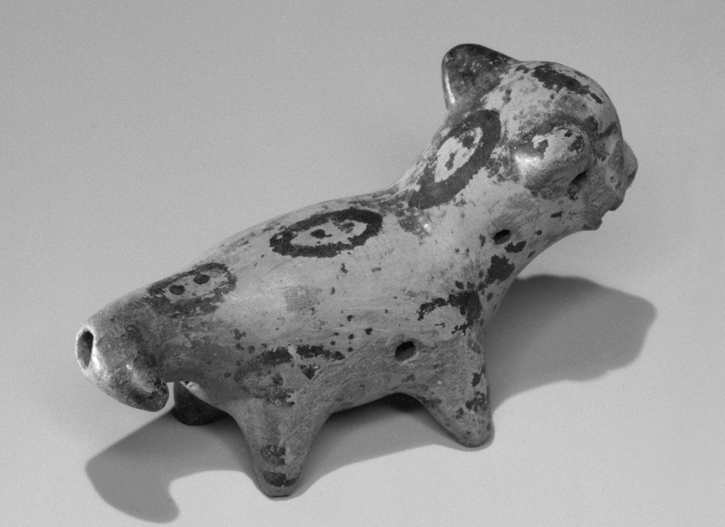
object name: pottery whistle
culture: costa rican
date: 800-1525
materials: pottery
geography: costa rica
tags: animals